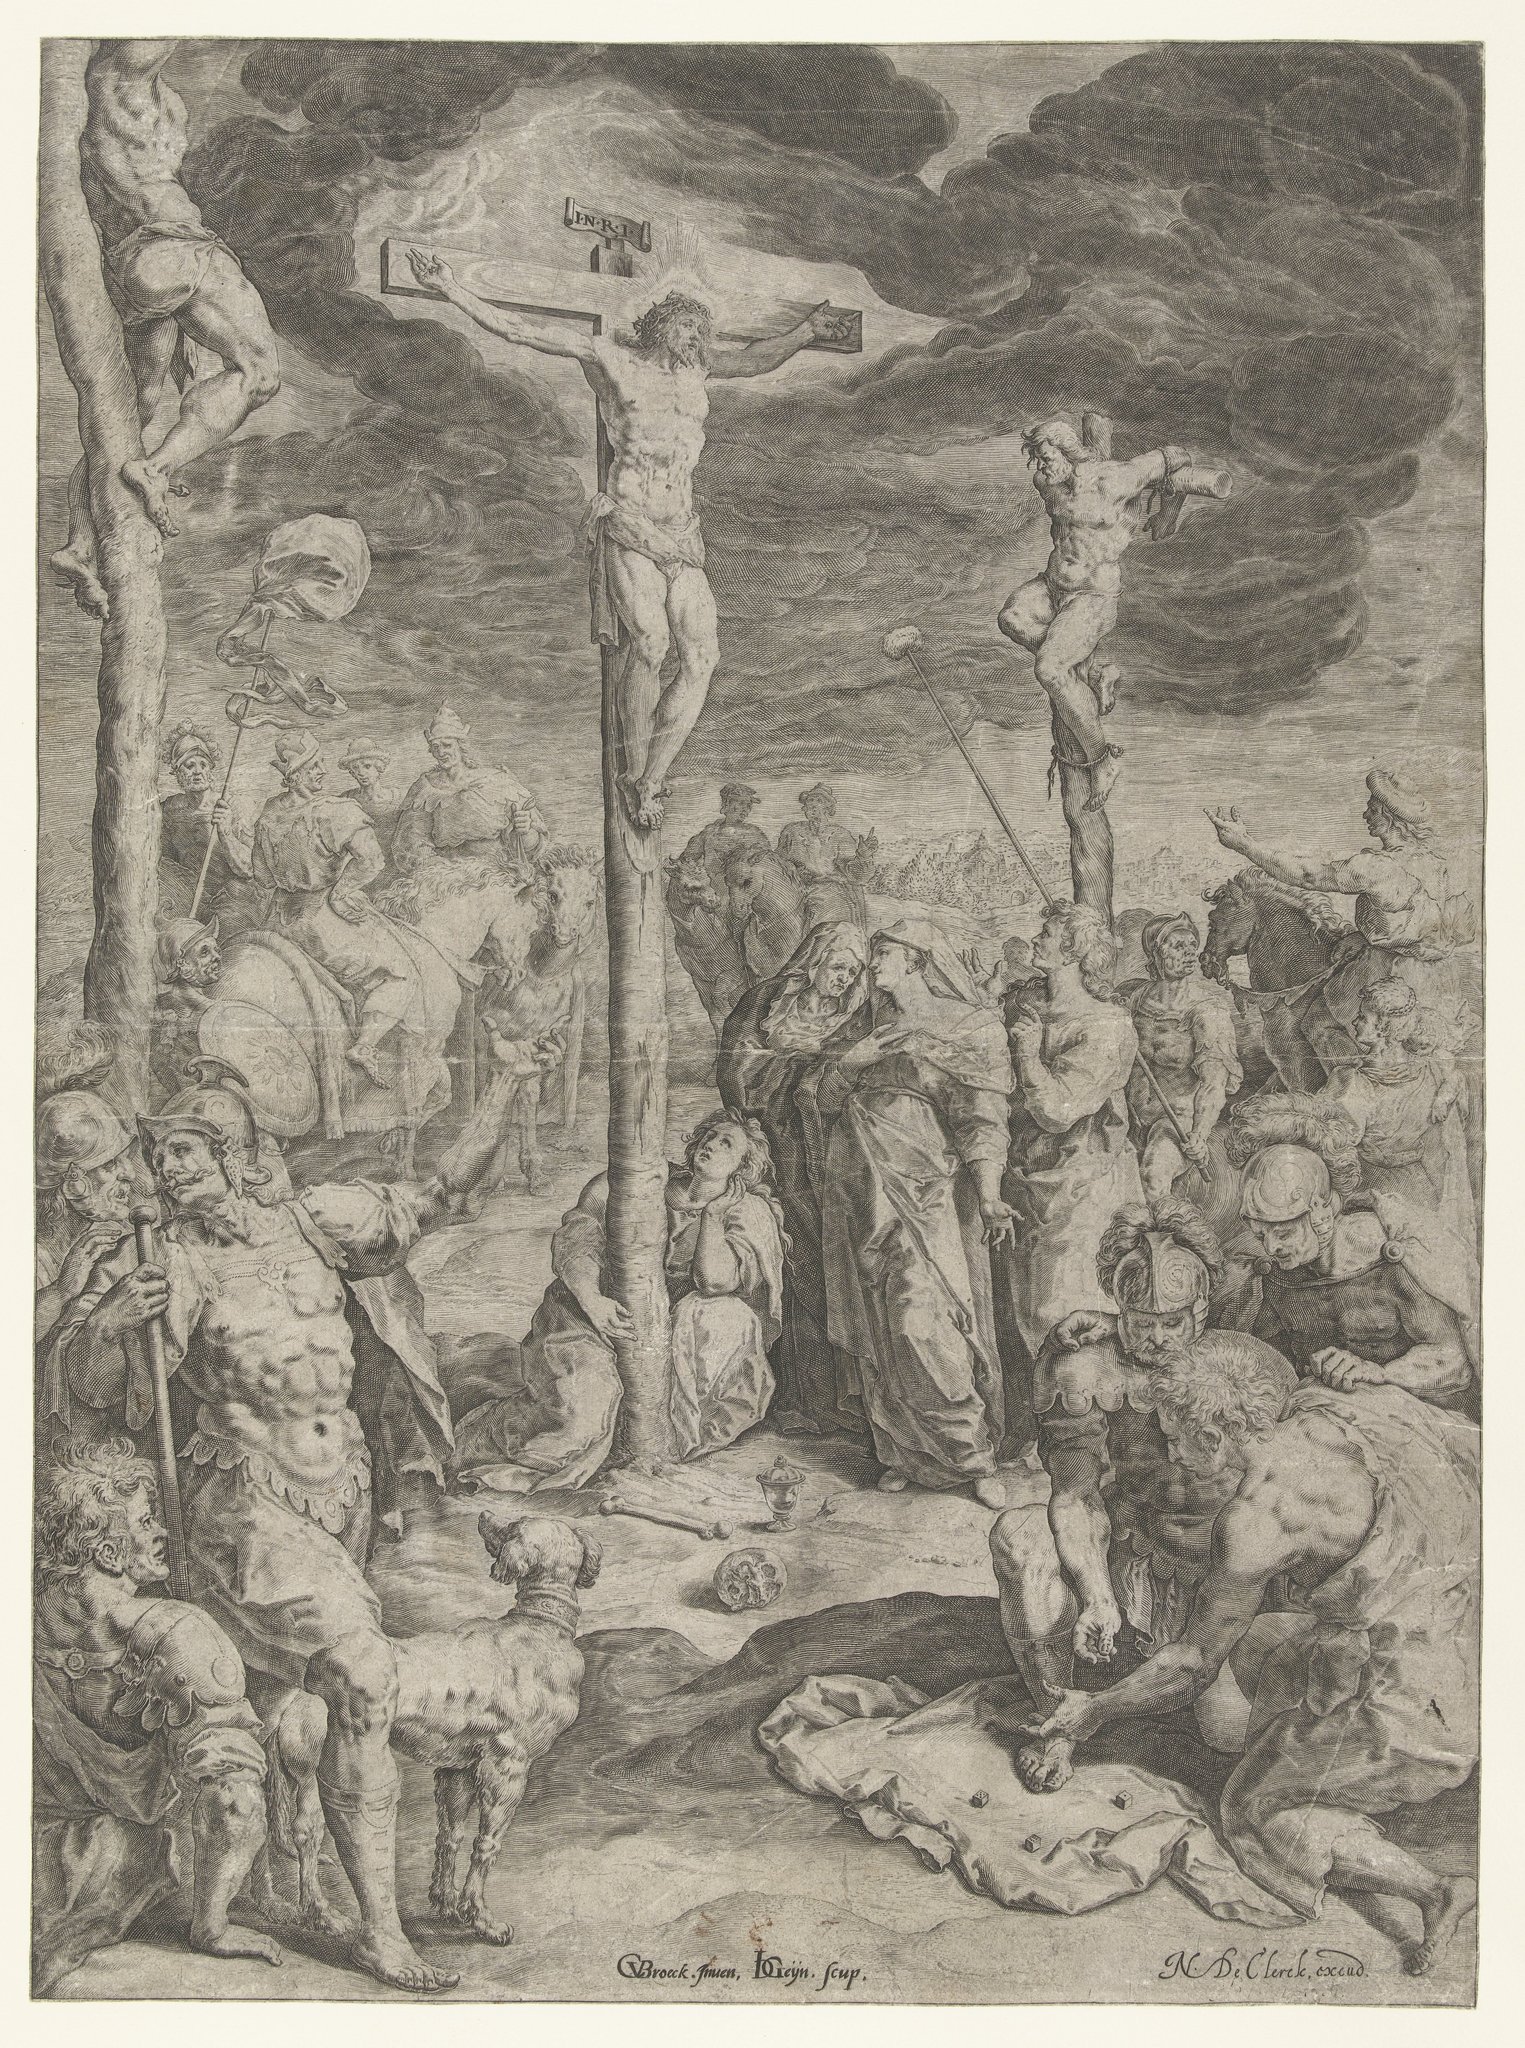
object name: print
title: Kruisiging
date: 1588-1592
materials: paper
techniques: engraving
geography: netherlands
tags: the crucifixion of christ: christ's death on the cross; golgotha (matthew 27:45-58; mark 15:33-45; luke 23:44-52; john 19:25-38)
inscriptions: collector's mark: Lugt 2228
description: Christus aan het kruis tussen de twee gekruisigde misdadigers in. Om het kruis veel verschillende figuren: zijn moeder Maria, Johannes de Evangelist, Maria Magdalena, de sponsdrager, Romeinse soldaten (een aantal dobbelend om Christus' kleding), ruiters, een hond.